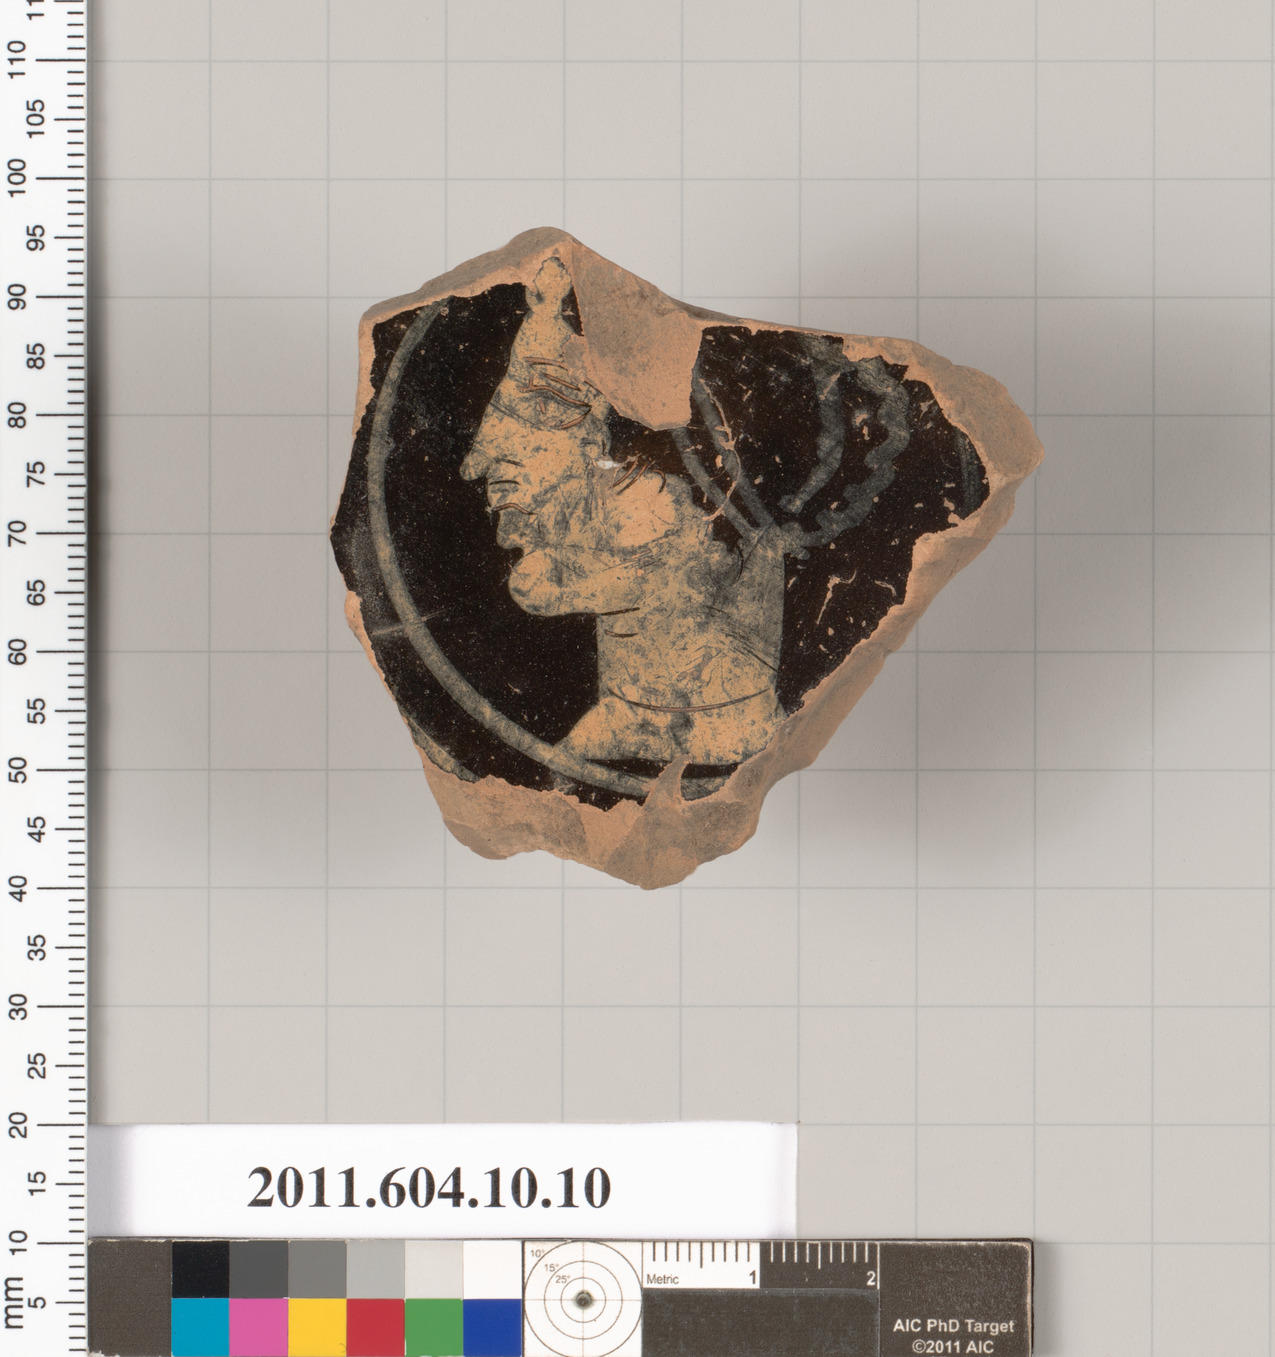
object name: kylix fragment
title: Terracotta fragment of a kylix (drinking cup)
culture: etruscan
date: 434-368 BCE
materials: terracotta